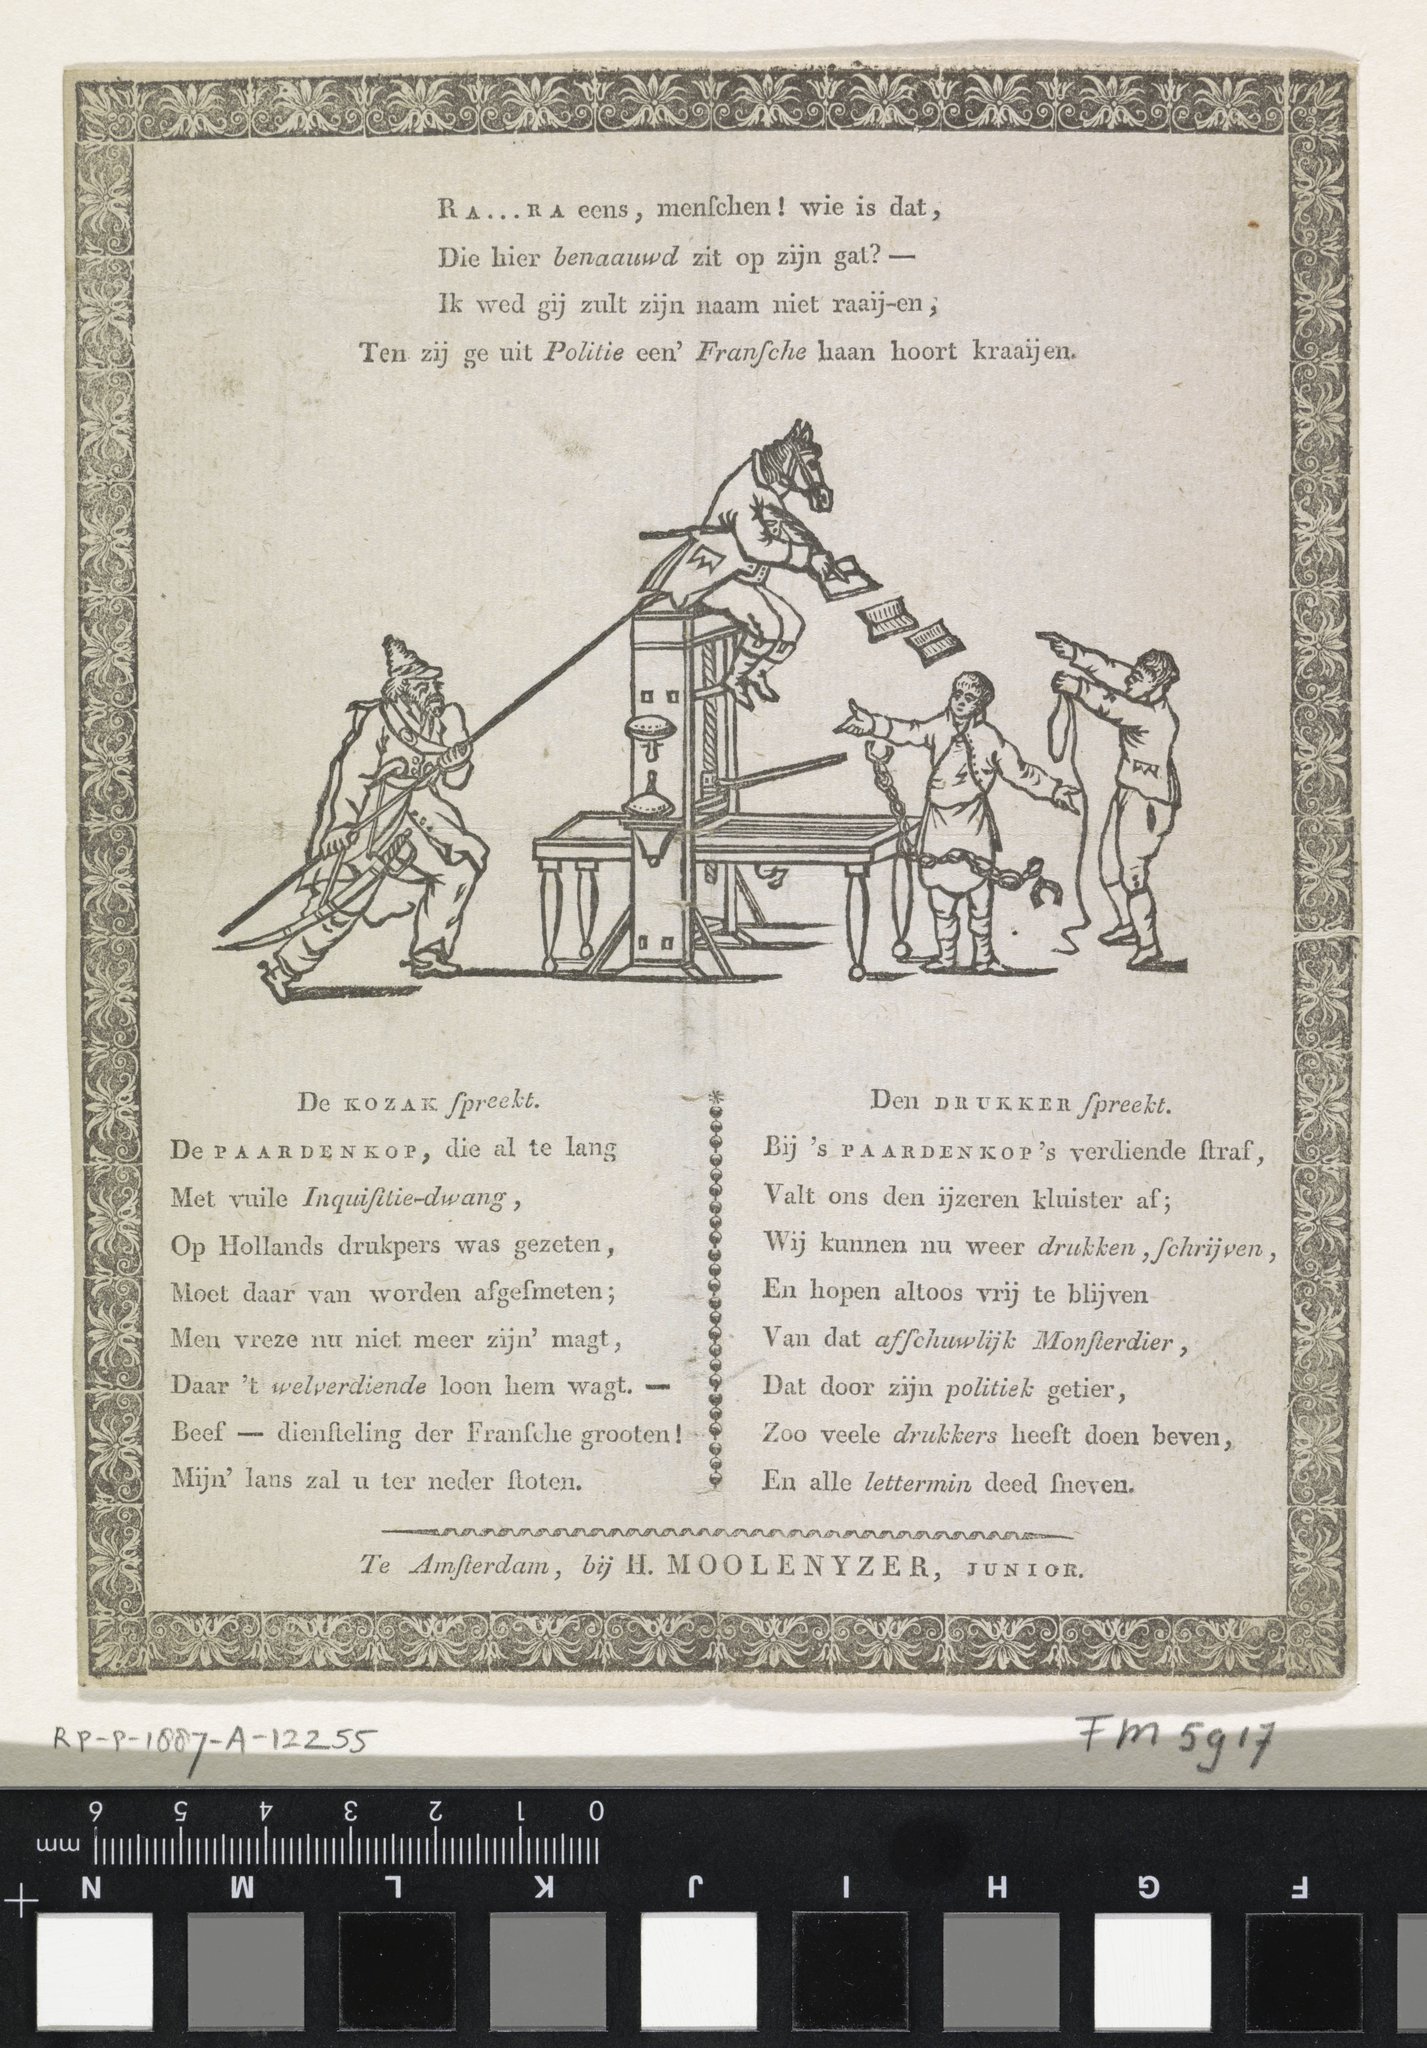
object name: print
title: Spotprent op Van Ray, inspecteur van de boekhandel, tijdens het Franse bestuur, 1813.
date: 1813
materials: paper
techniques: letterpress printing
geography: amsterdam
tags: censorship, printing press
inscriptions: collector's mark: Lugt 2228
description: Spotprent op C.A. van Raay, inspecteur of censor van de boekhandel, tijdens het Franse bestuur dat valt in 1813. Een man met paardenkop, bovenop een drukpers gezeten wordt er door een kozak met zijn lans afgestoten. Rechts staan twee drukkers bij wie op het zien hiervan de boeien van de handen vallen. Boven de voorstelling een vierregelig vers; onder de voorstelling een 16-regelig vers in twee kolommen.